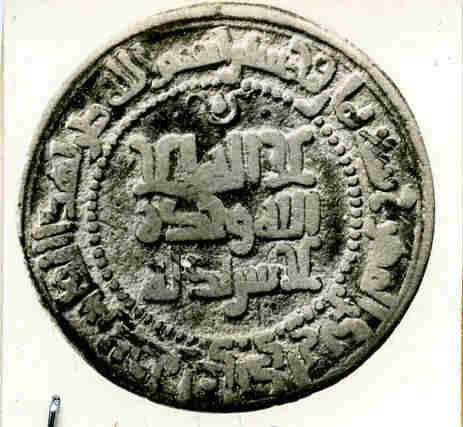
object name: coin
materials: copper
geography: uzbekistan